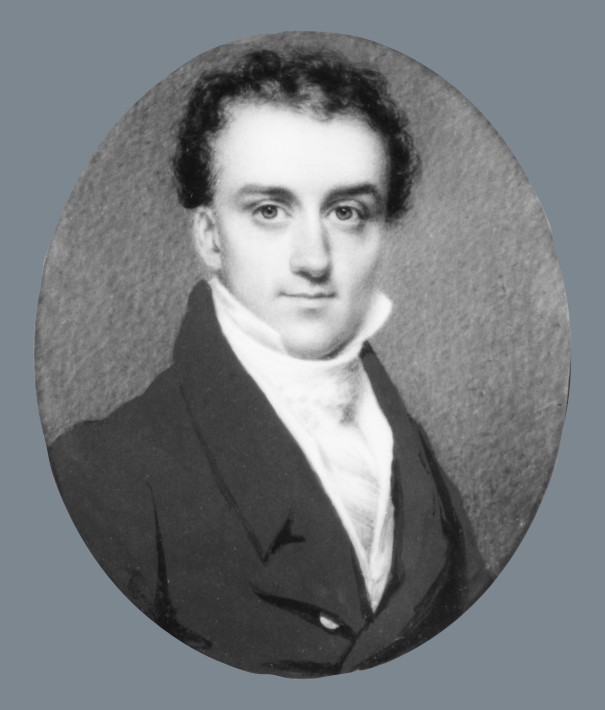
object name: painting, miniature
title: Portrait of a Gentleman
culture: american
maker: nathaniel rogers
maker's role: artist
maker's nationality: american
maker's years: 1788-1844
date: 1825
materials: ivory, watercolor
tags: men,portraits